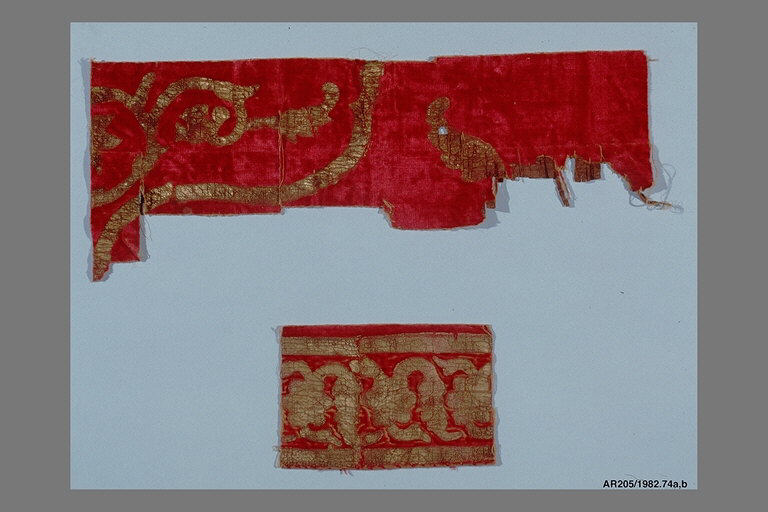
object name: textile fragment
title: Textile Fragments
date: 1635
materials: gold leaf, silk, velvet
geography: india